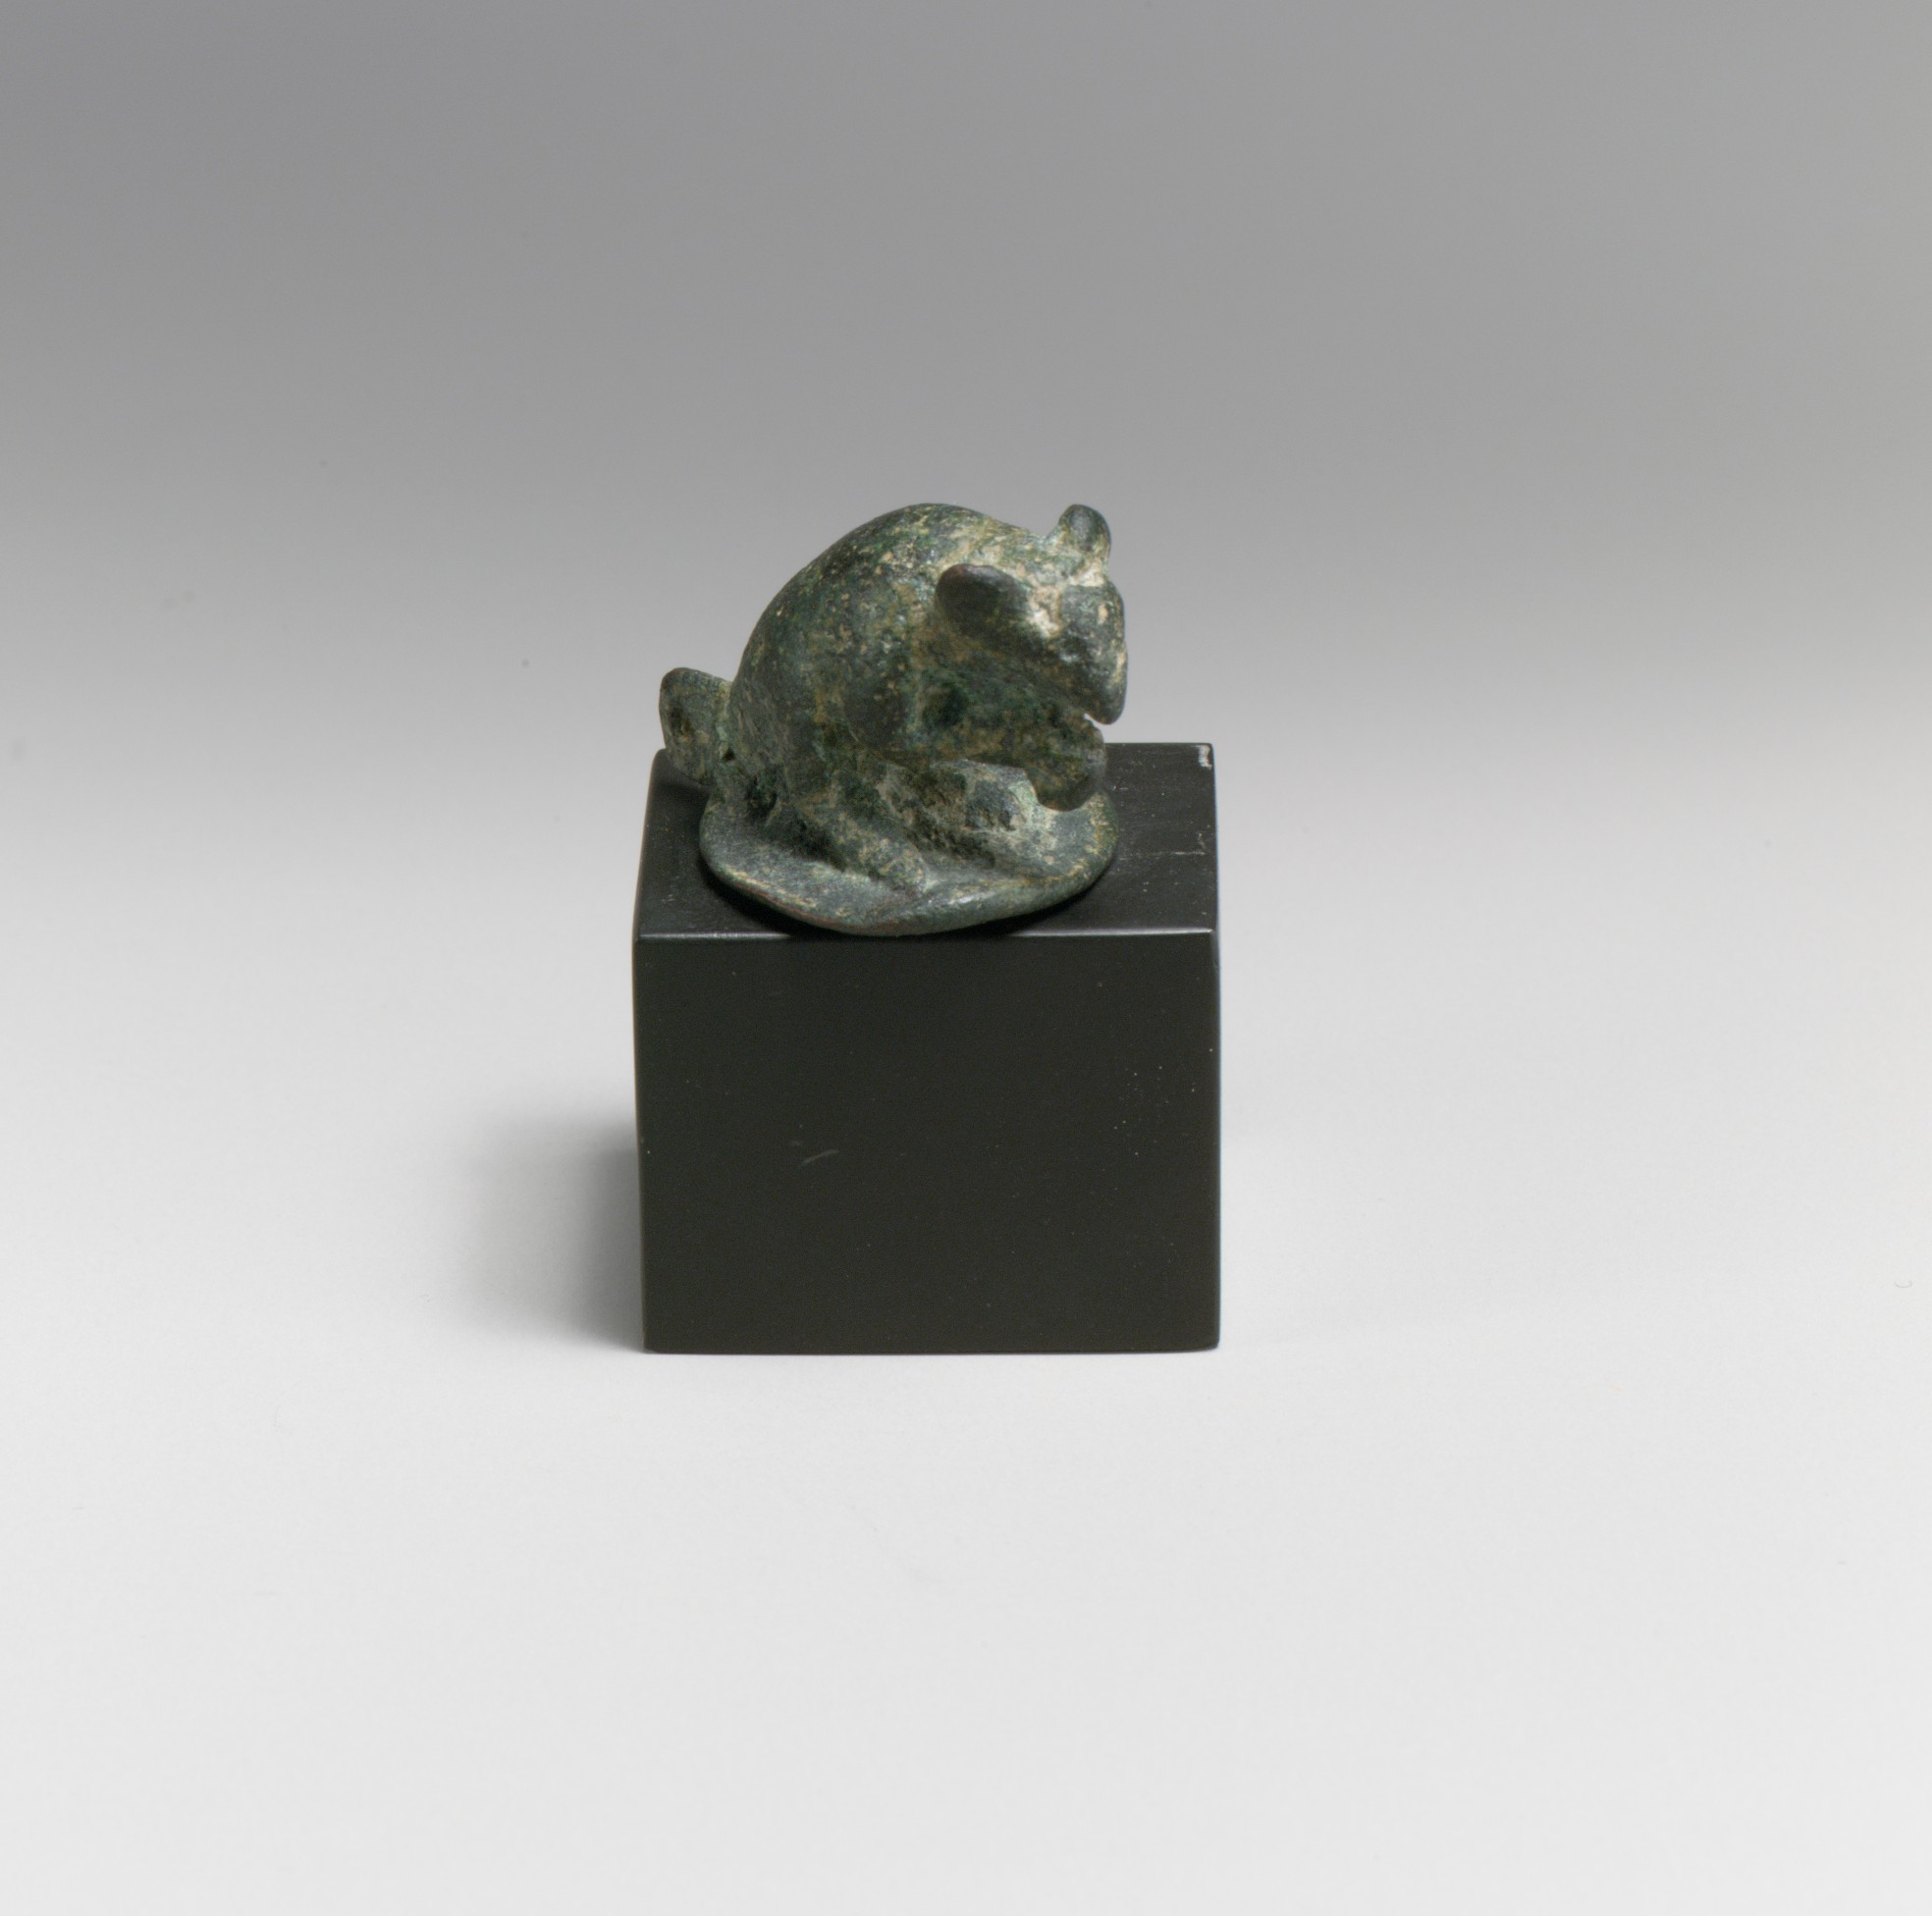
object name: statuette of a mouse from a lamp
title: Bronze statuette of a mouse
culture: roman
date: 1-300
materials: bronze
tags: mice